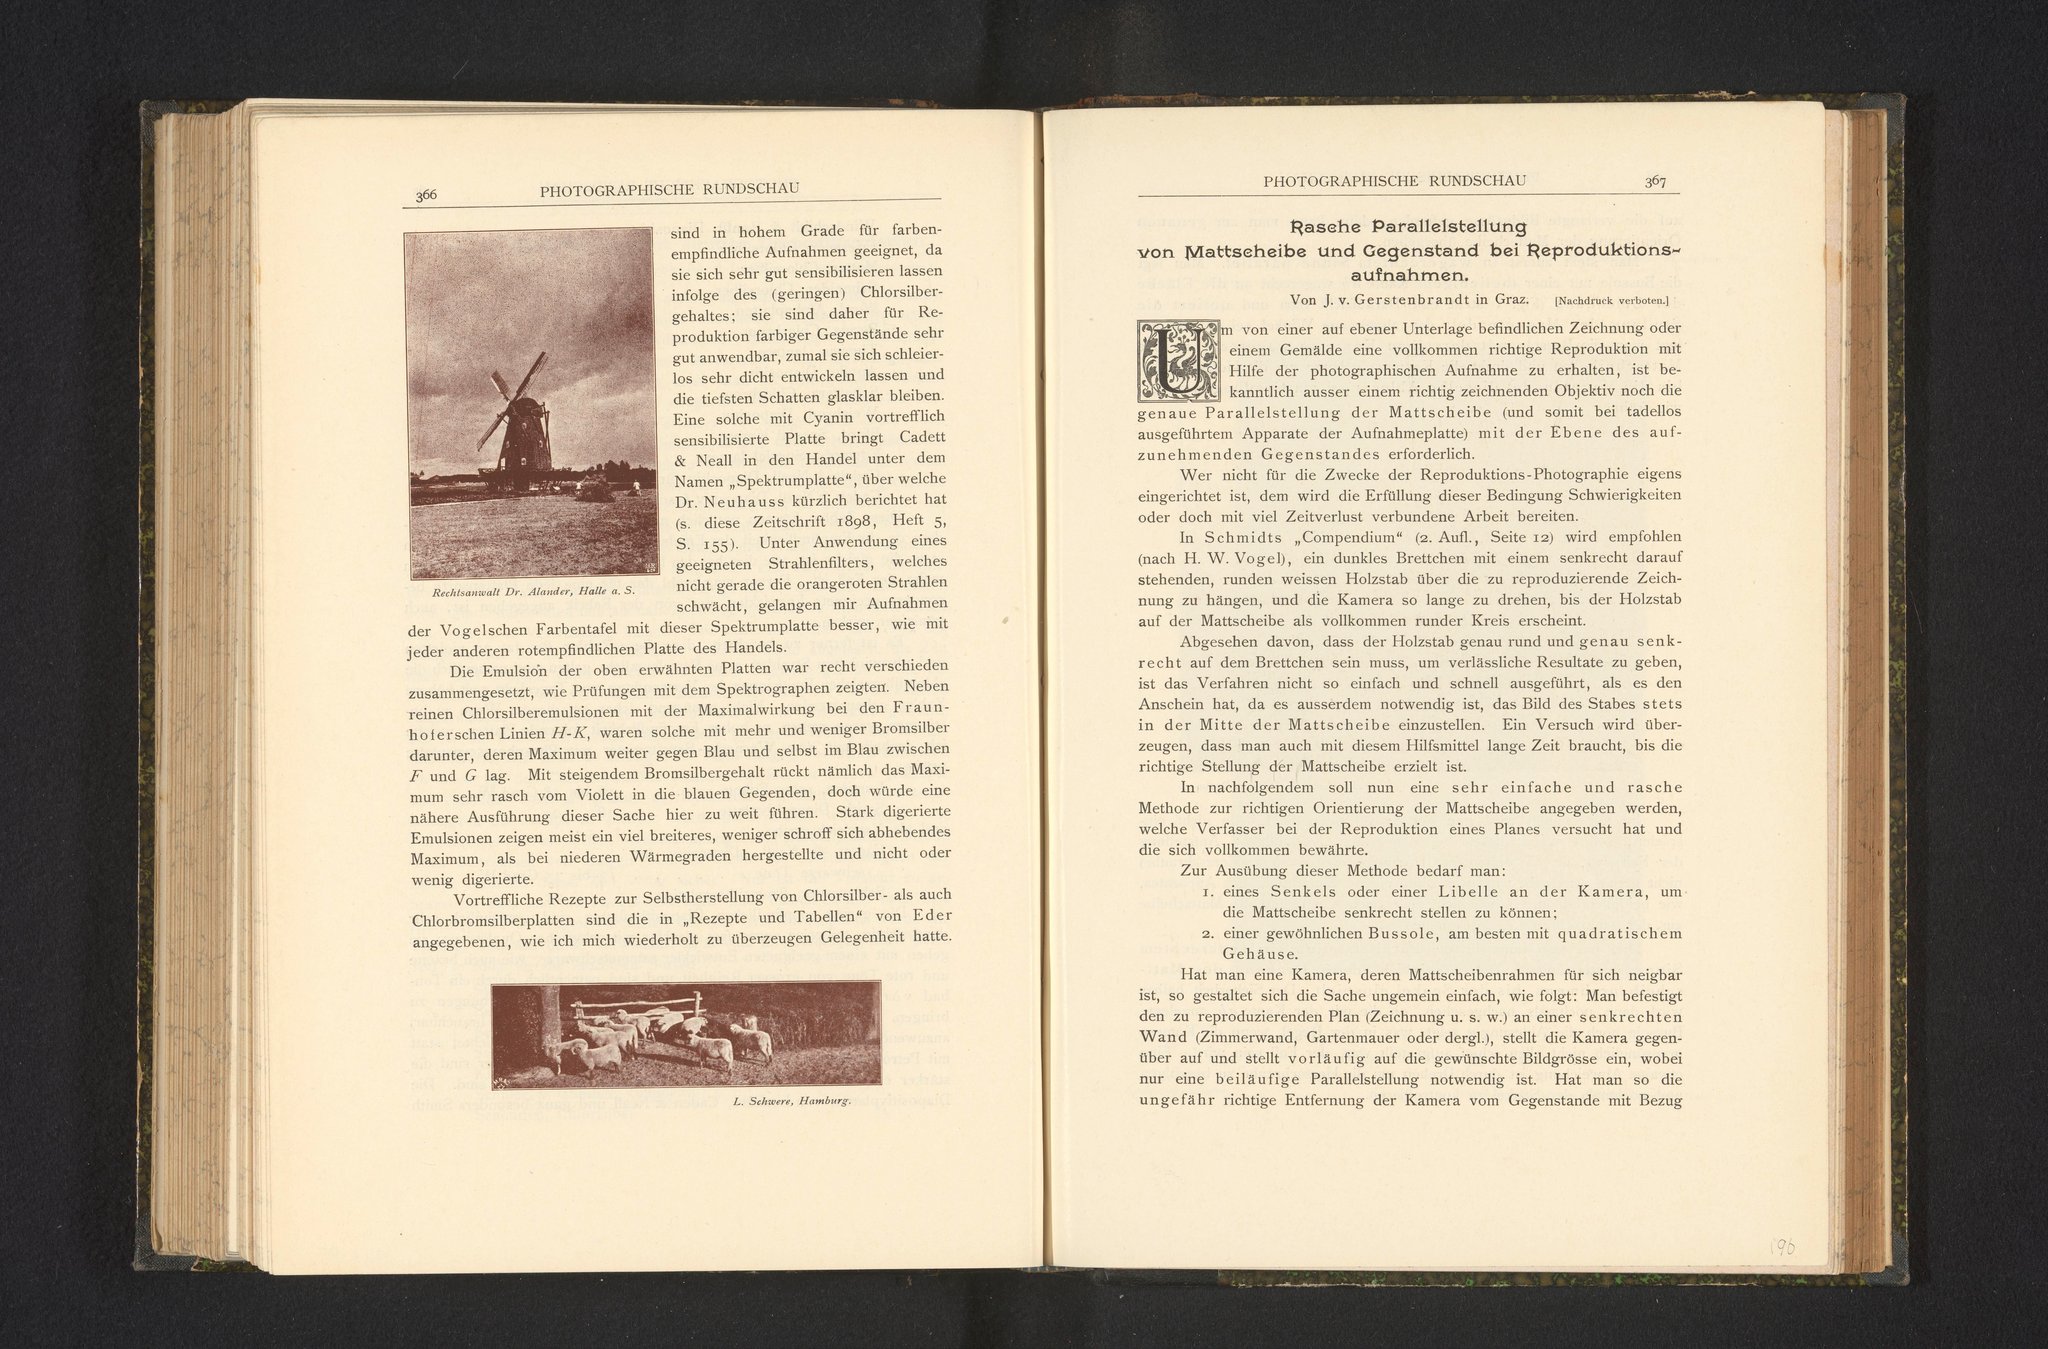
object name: photomechanical print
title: Gezicht op een molen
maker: dr. alander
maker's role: advocaat, fotograaf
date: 1893-1898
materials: paper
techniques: autotype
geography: berlin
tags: windmill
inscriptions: monogram: ‘MR/ &Co’